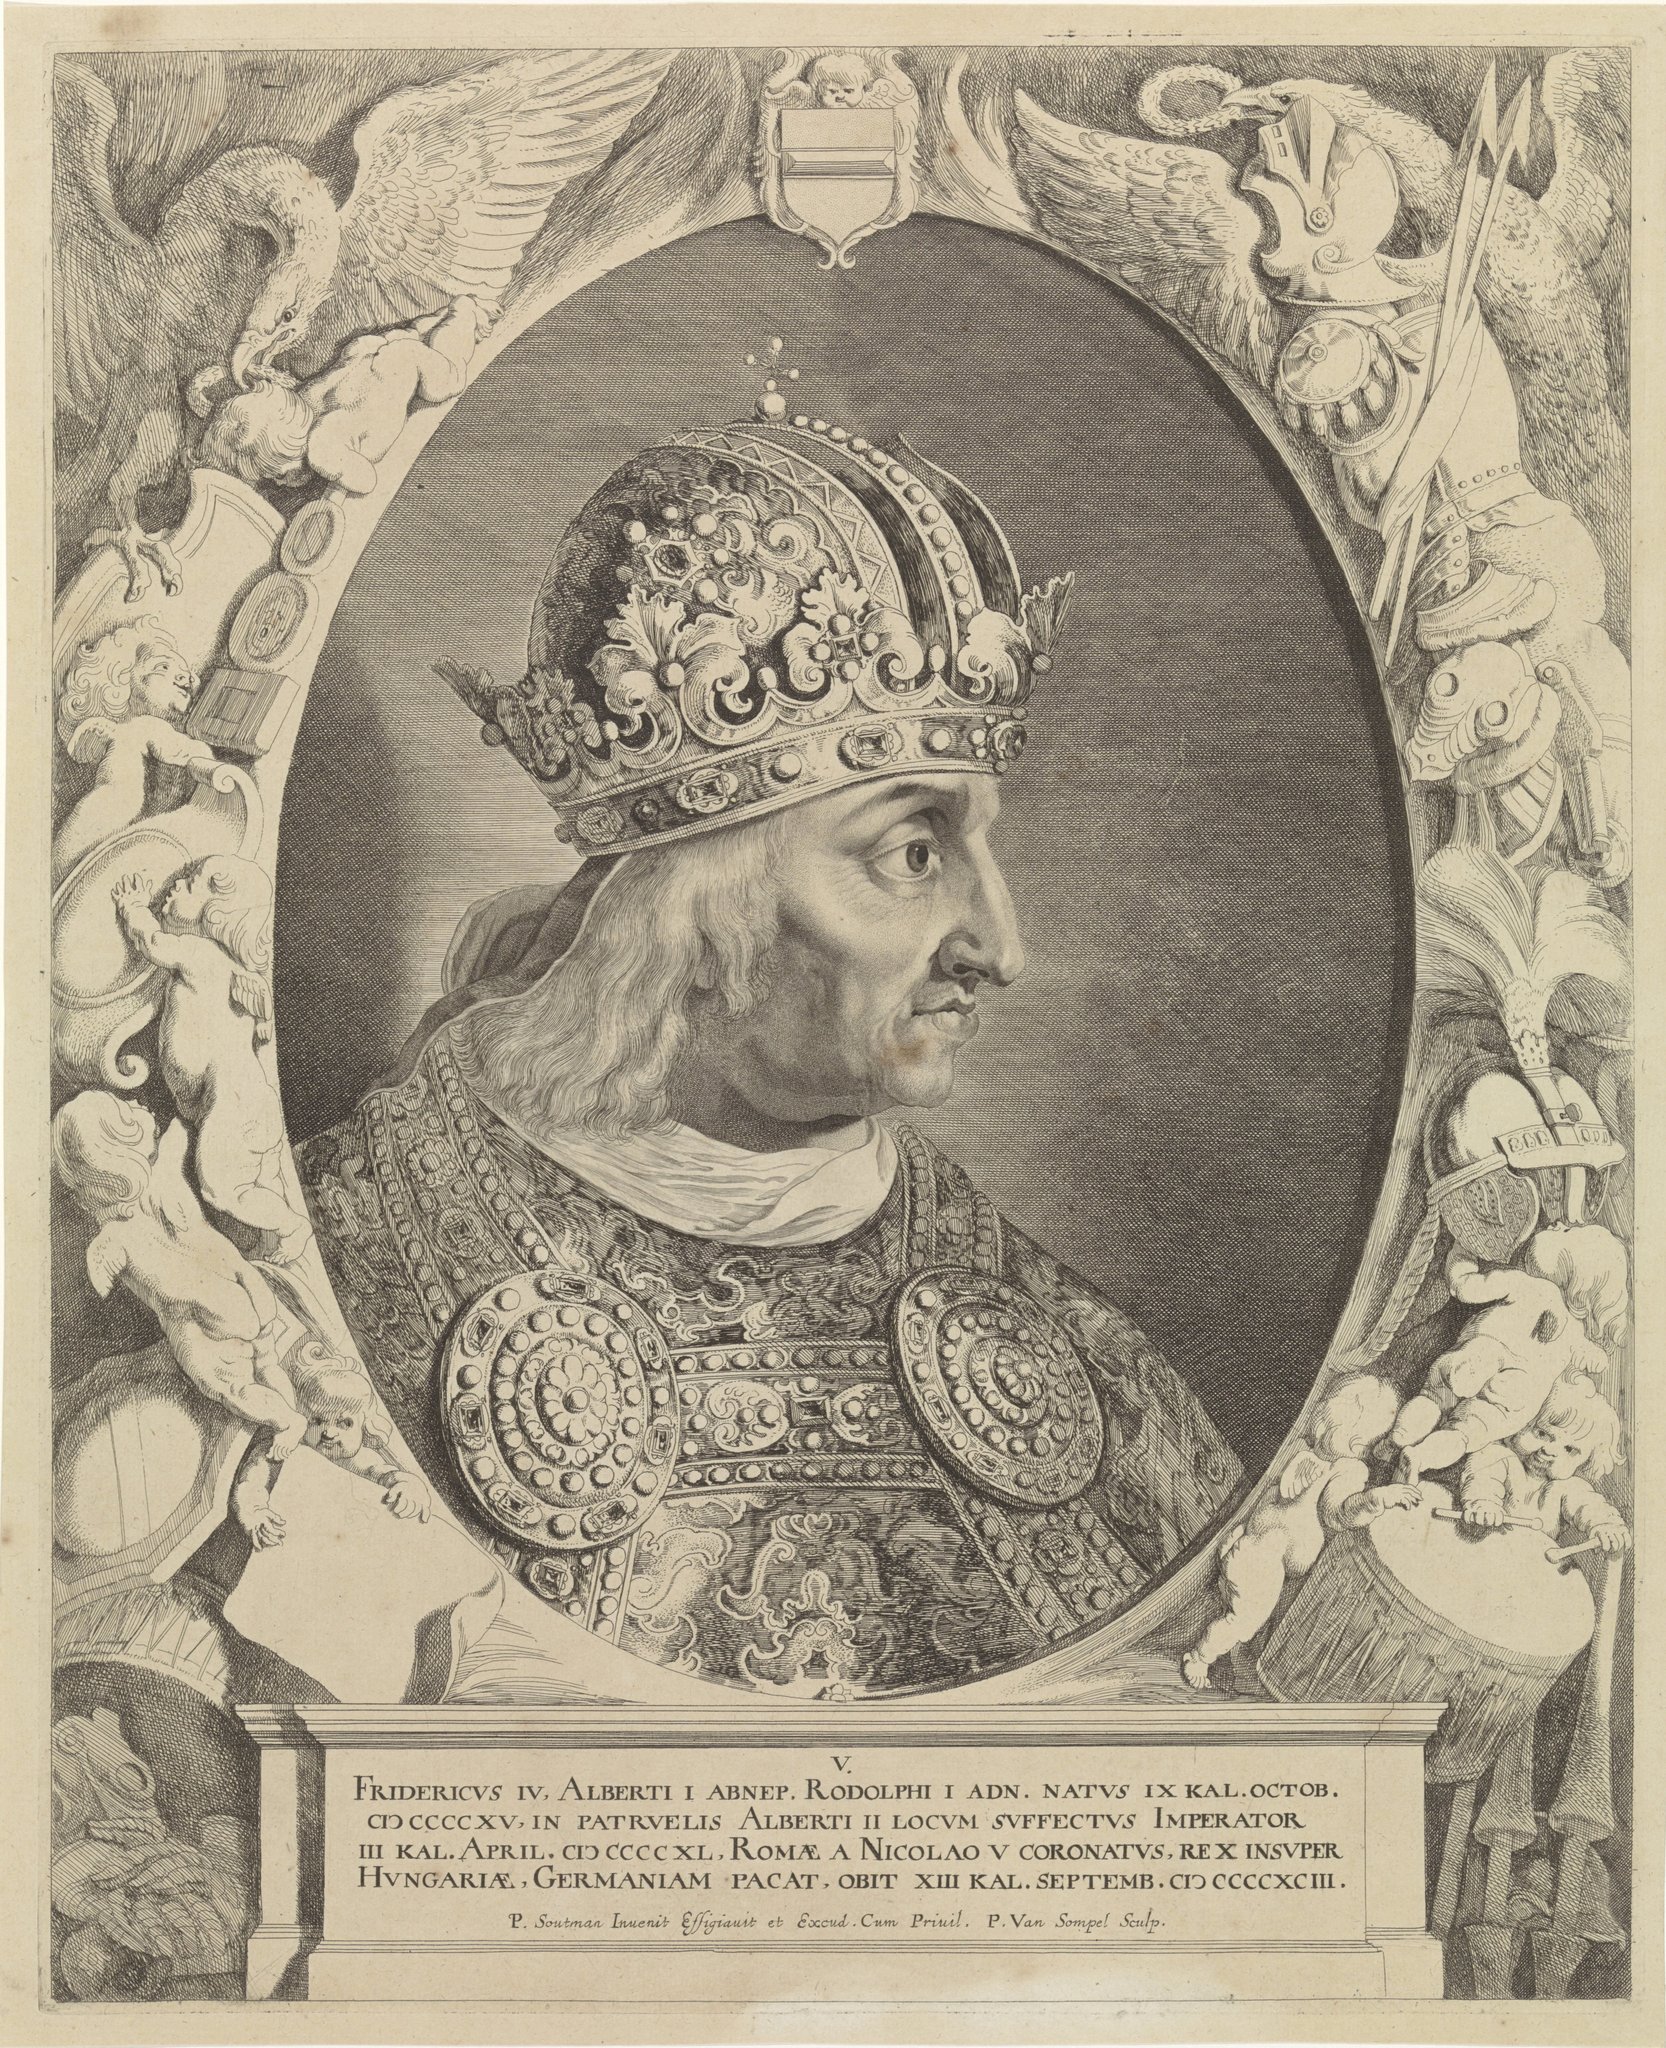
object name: print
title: Portret van Frederik III van Habsburg (Duits keizer), als koning Frederik IV van Duitsland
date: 1644-1650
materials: paper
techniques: engraving, etching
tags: crown (symbol of sovereignty)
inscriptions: collector's mark: Lugt 2228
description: Portret van Frederik III van Habsburg (Duits keizer), als koning Frederik IV van Duitsland, met kroon. Het portret wordt omlijst door een randversiering met putti, wapens en harnasonderdelen. In de beide bovenhoeken een adelaar, in het midden zijn wapenschild. Onder het portret een voetstuk met daarop in het Latijn zijn naam, titels en een korte levensbeschrijving. Genummerd "V".